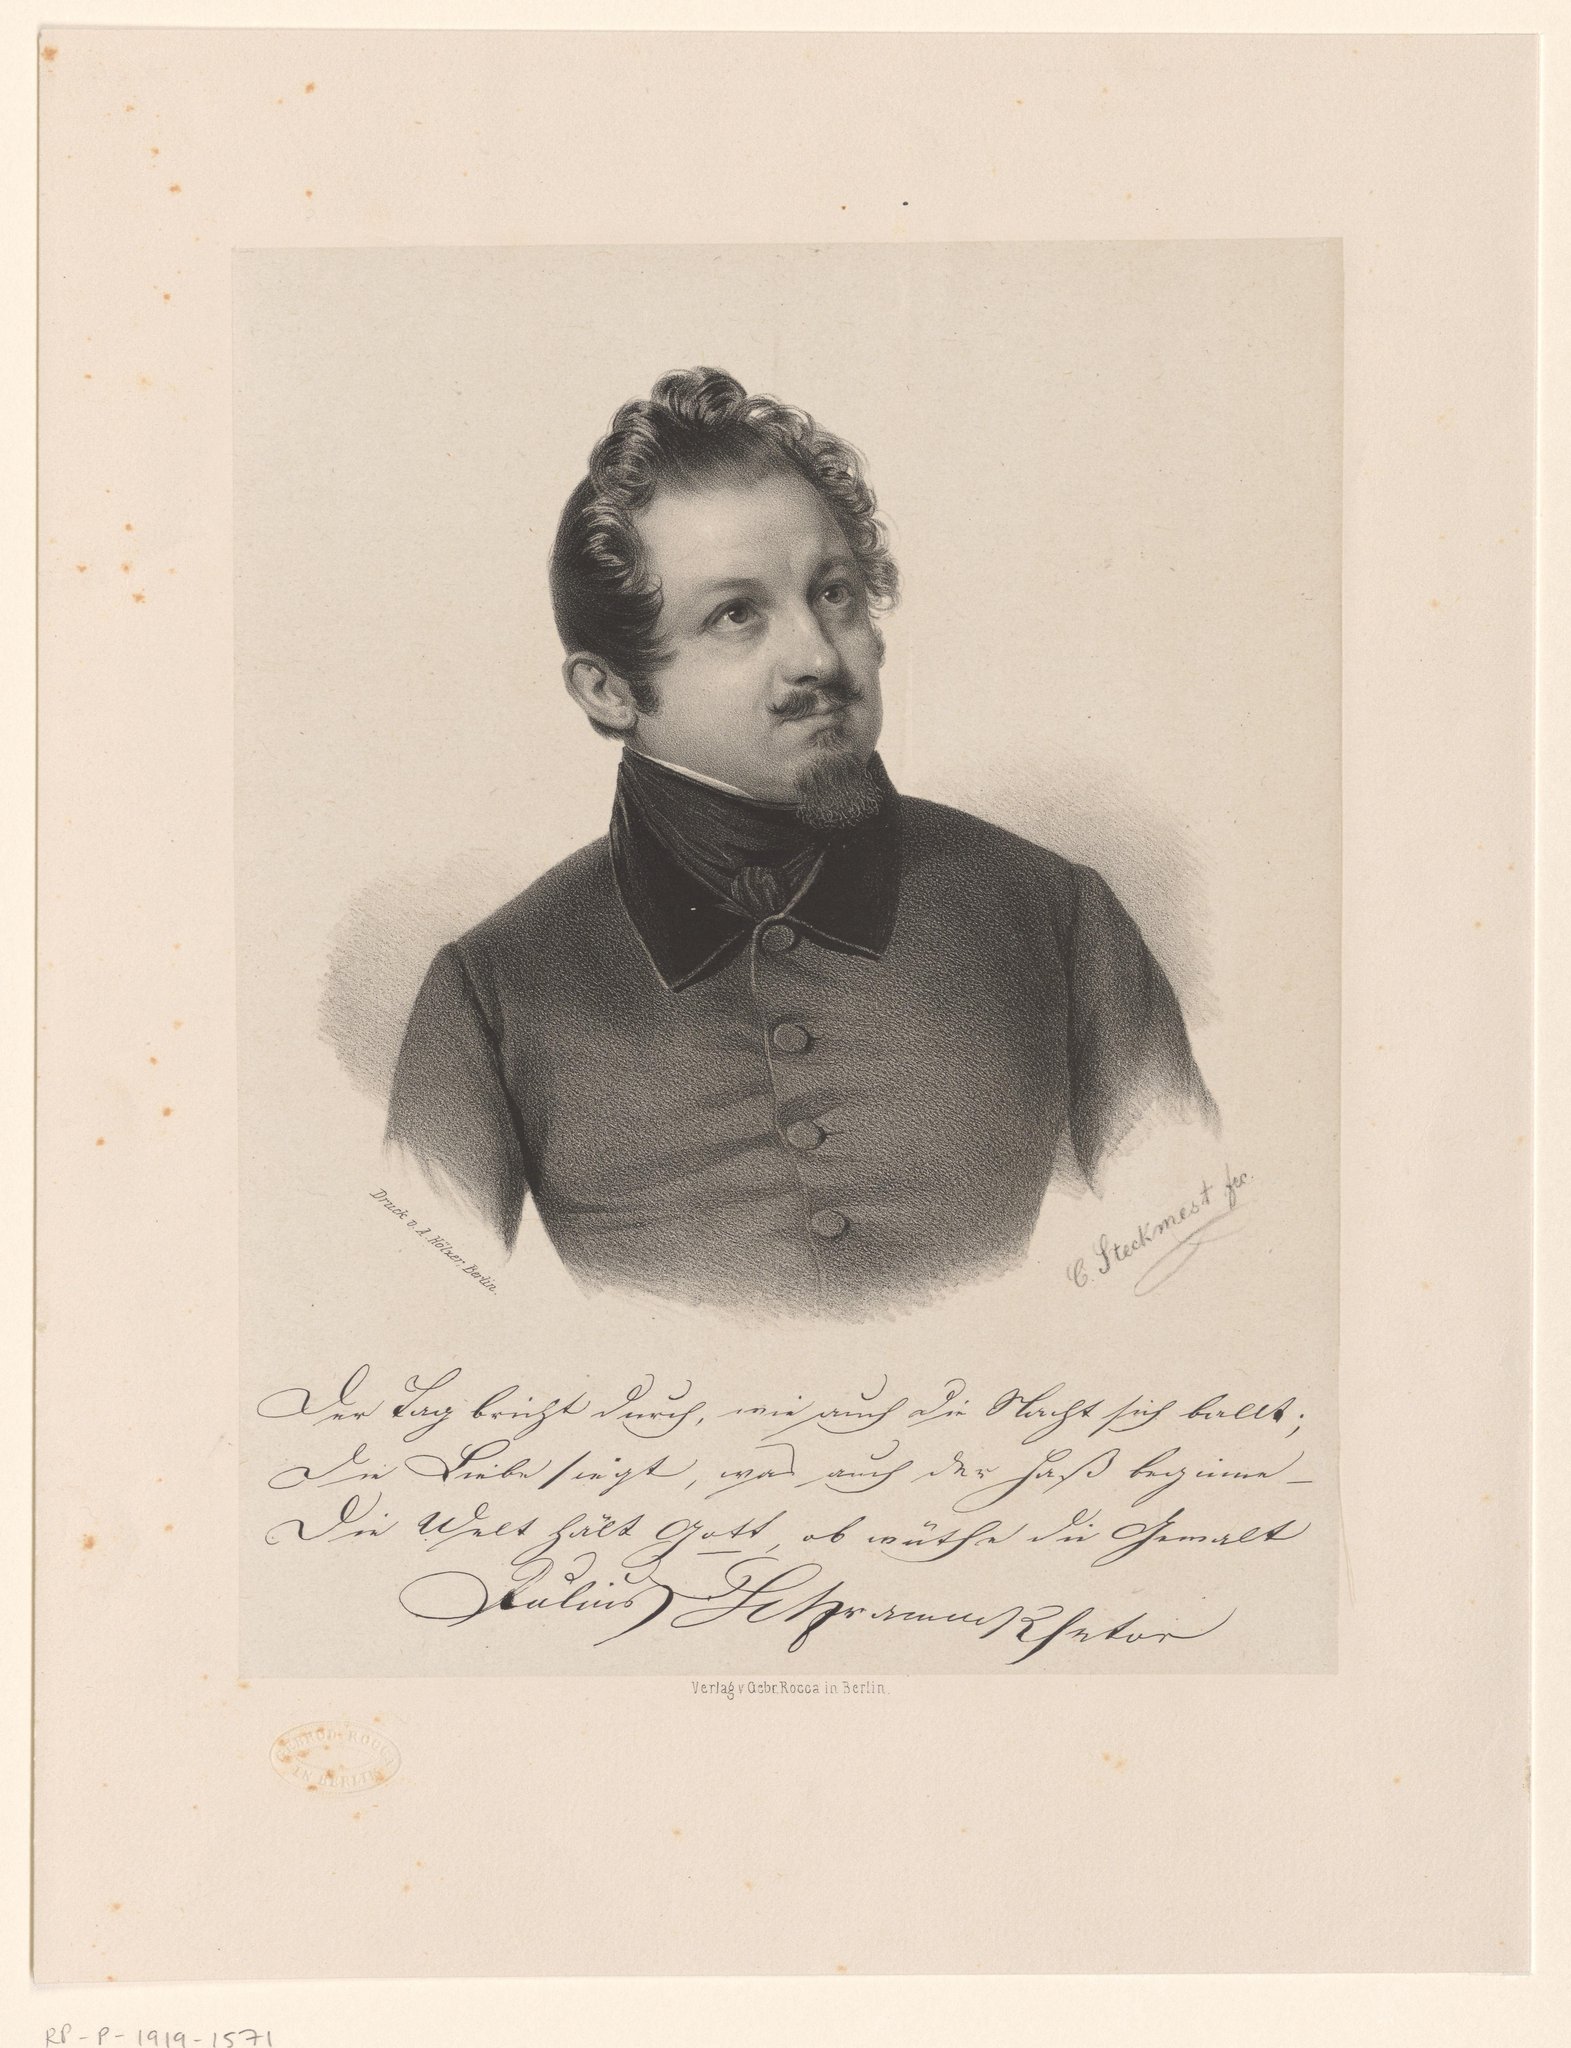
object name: print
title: Portret van Julius Schramm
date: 1830-1863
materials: paper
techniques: lithograph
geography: berlin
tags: historical persons, portrait of actor, actress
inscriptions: check stamp: Lugt 2141c, collector's mark: Lugt 2228